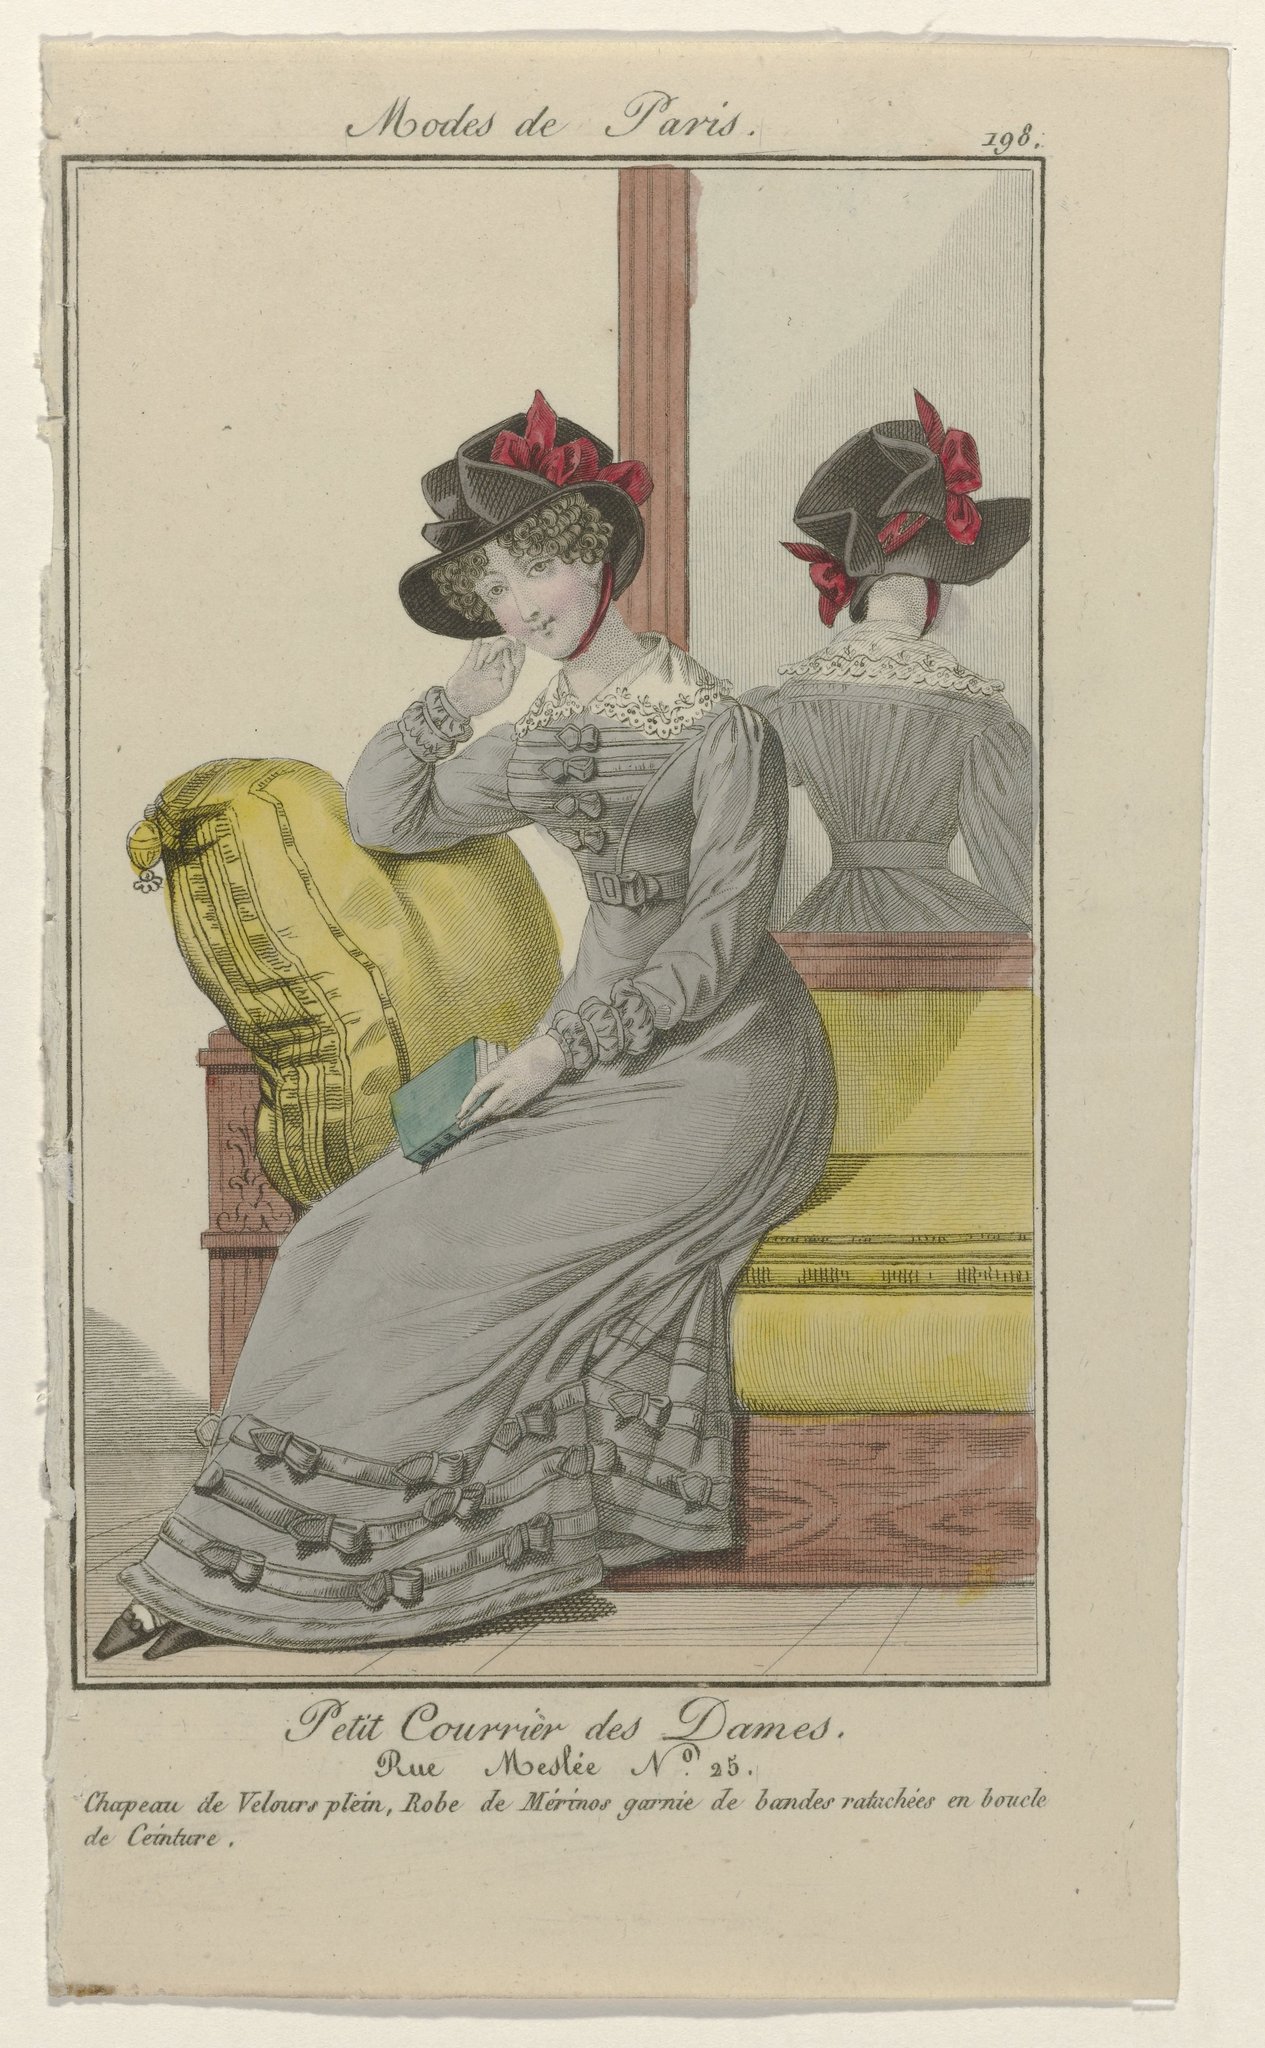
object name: fashion print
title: Petit Courrier des Dames, ca. 1823, No. 198 : Chapeau de velours plein (...)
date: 1823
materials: paper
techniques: engraving, hand coloring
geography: paris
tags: ornamental parts of clothing (+ women's clothes), reflection (in a mirror) (+ back view), fashion plates, head-gear: hat (+ women's clothes), shoes, sandals (+ women's clothes), dress, gown (+ women's clothes), book, neck-gear ~ clothing (+ women's clothes), belt, girdle, waistband (+ women's clothes)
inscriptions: caption: ‘Chapeau de Velours plein, Robe de Mérinos garnie de bandes ratachées en boucle de Ceinture.’, title: ‘Modes de Paris’, address: ‘Rue Meslée No. 25’, title: ‘Petit Courrier des Dames’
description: Vrouw, zittend op een bank, met de rug naar een spiegel. Zij draagt een japon van merinowol, versierd met banden verbonden zoals een ceintuurgesp. Op het hoofd een hoed van fluweel. Prent uit het modetijdschrift Petit Courrier des Dames (1821-1868).